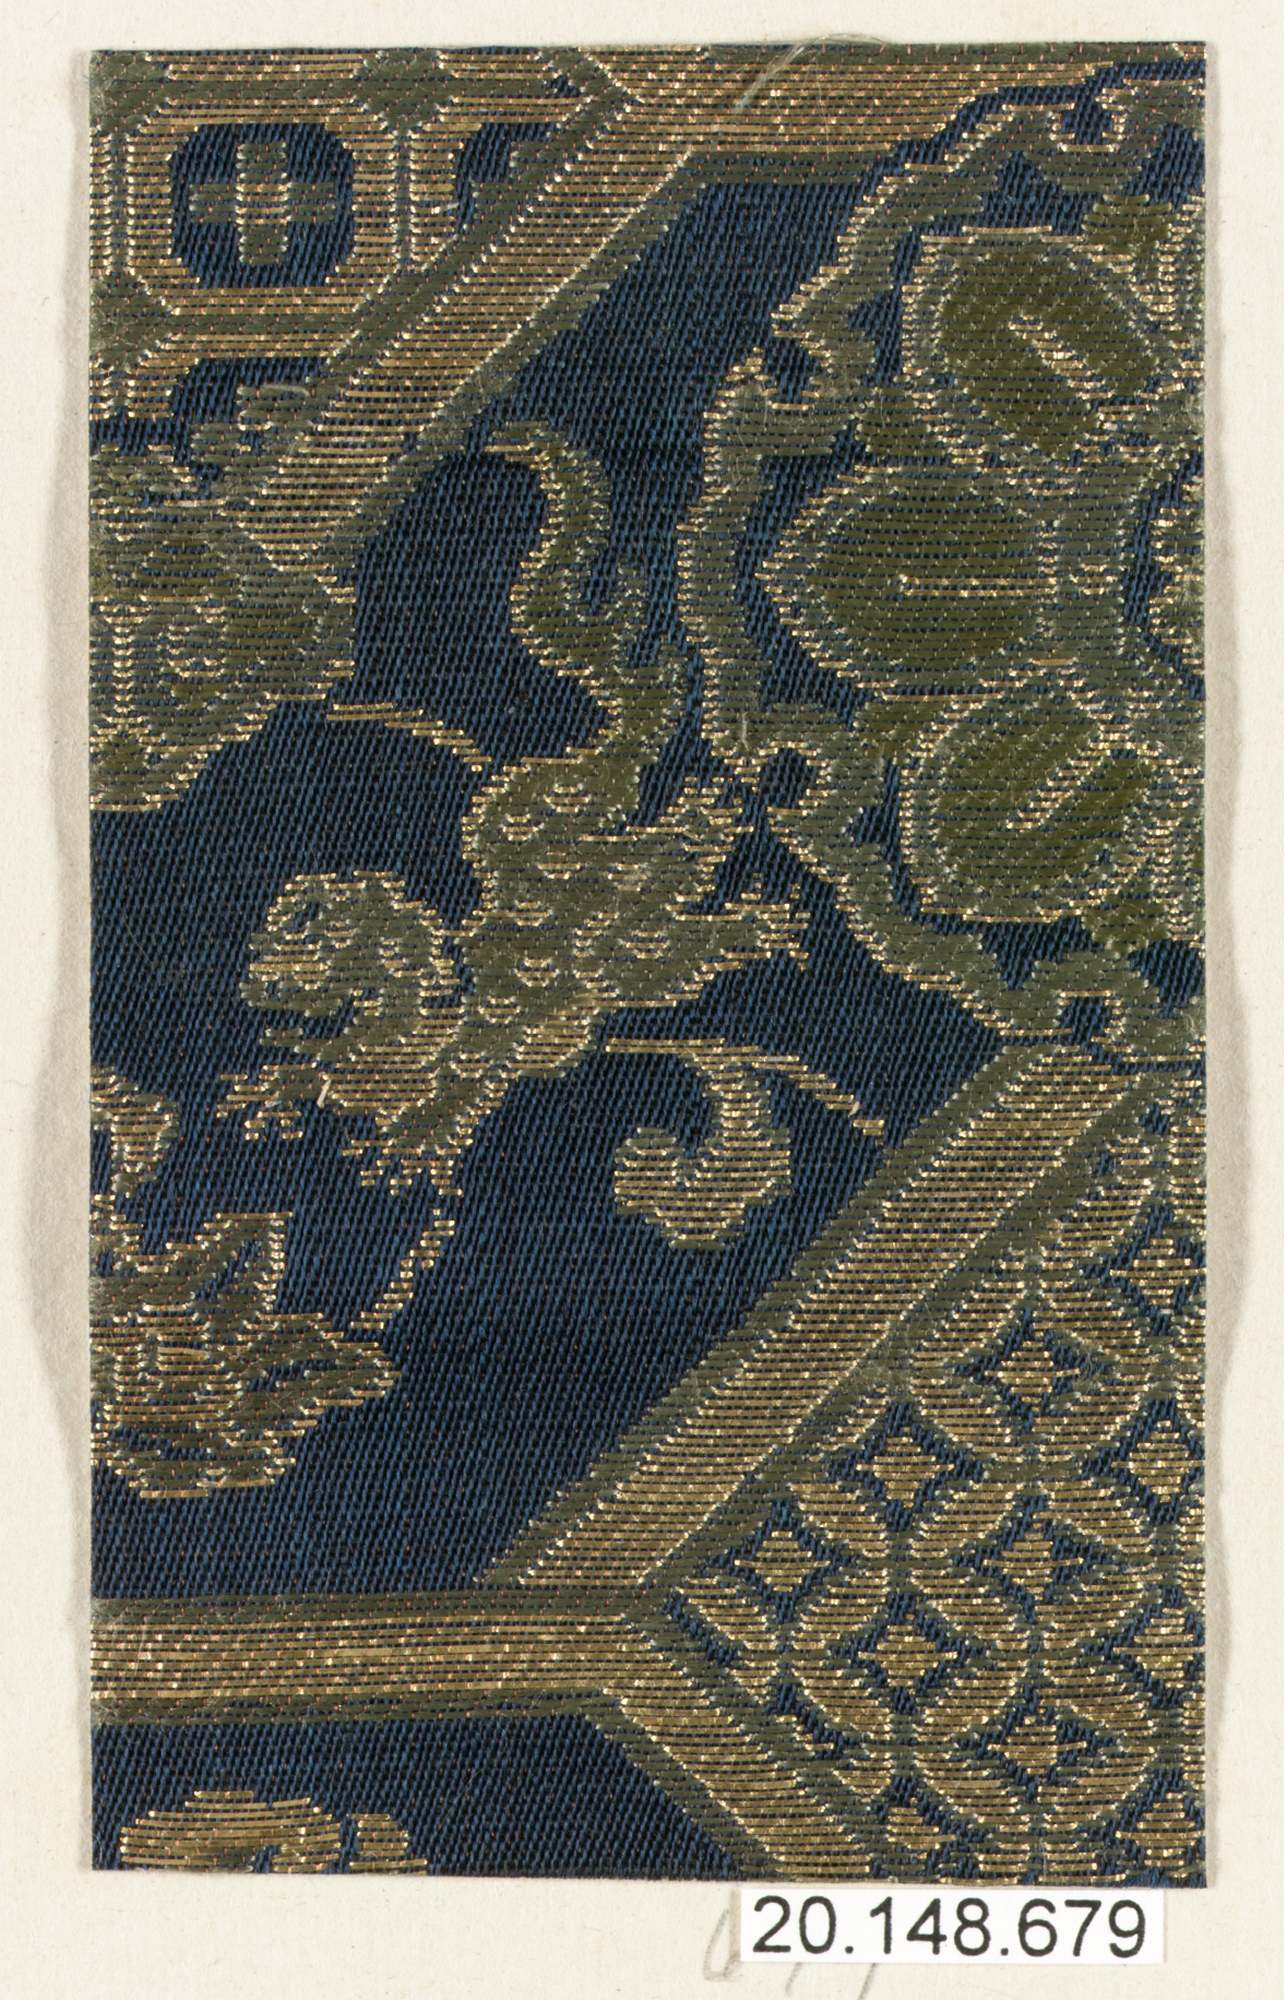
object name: piece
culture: japanese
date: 1701-1800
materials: silk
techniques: compound weave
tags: dragons